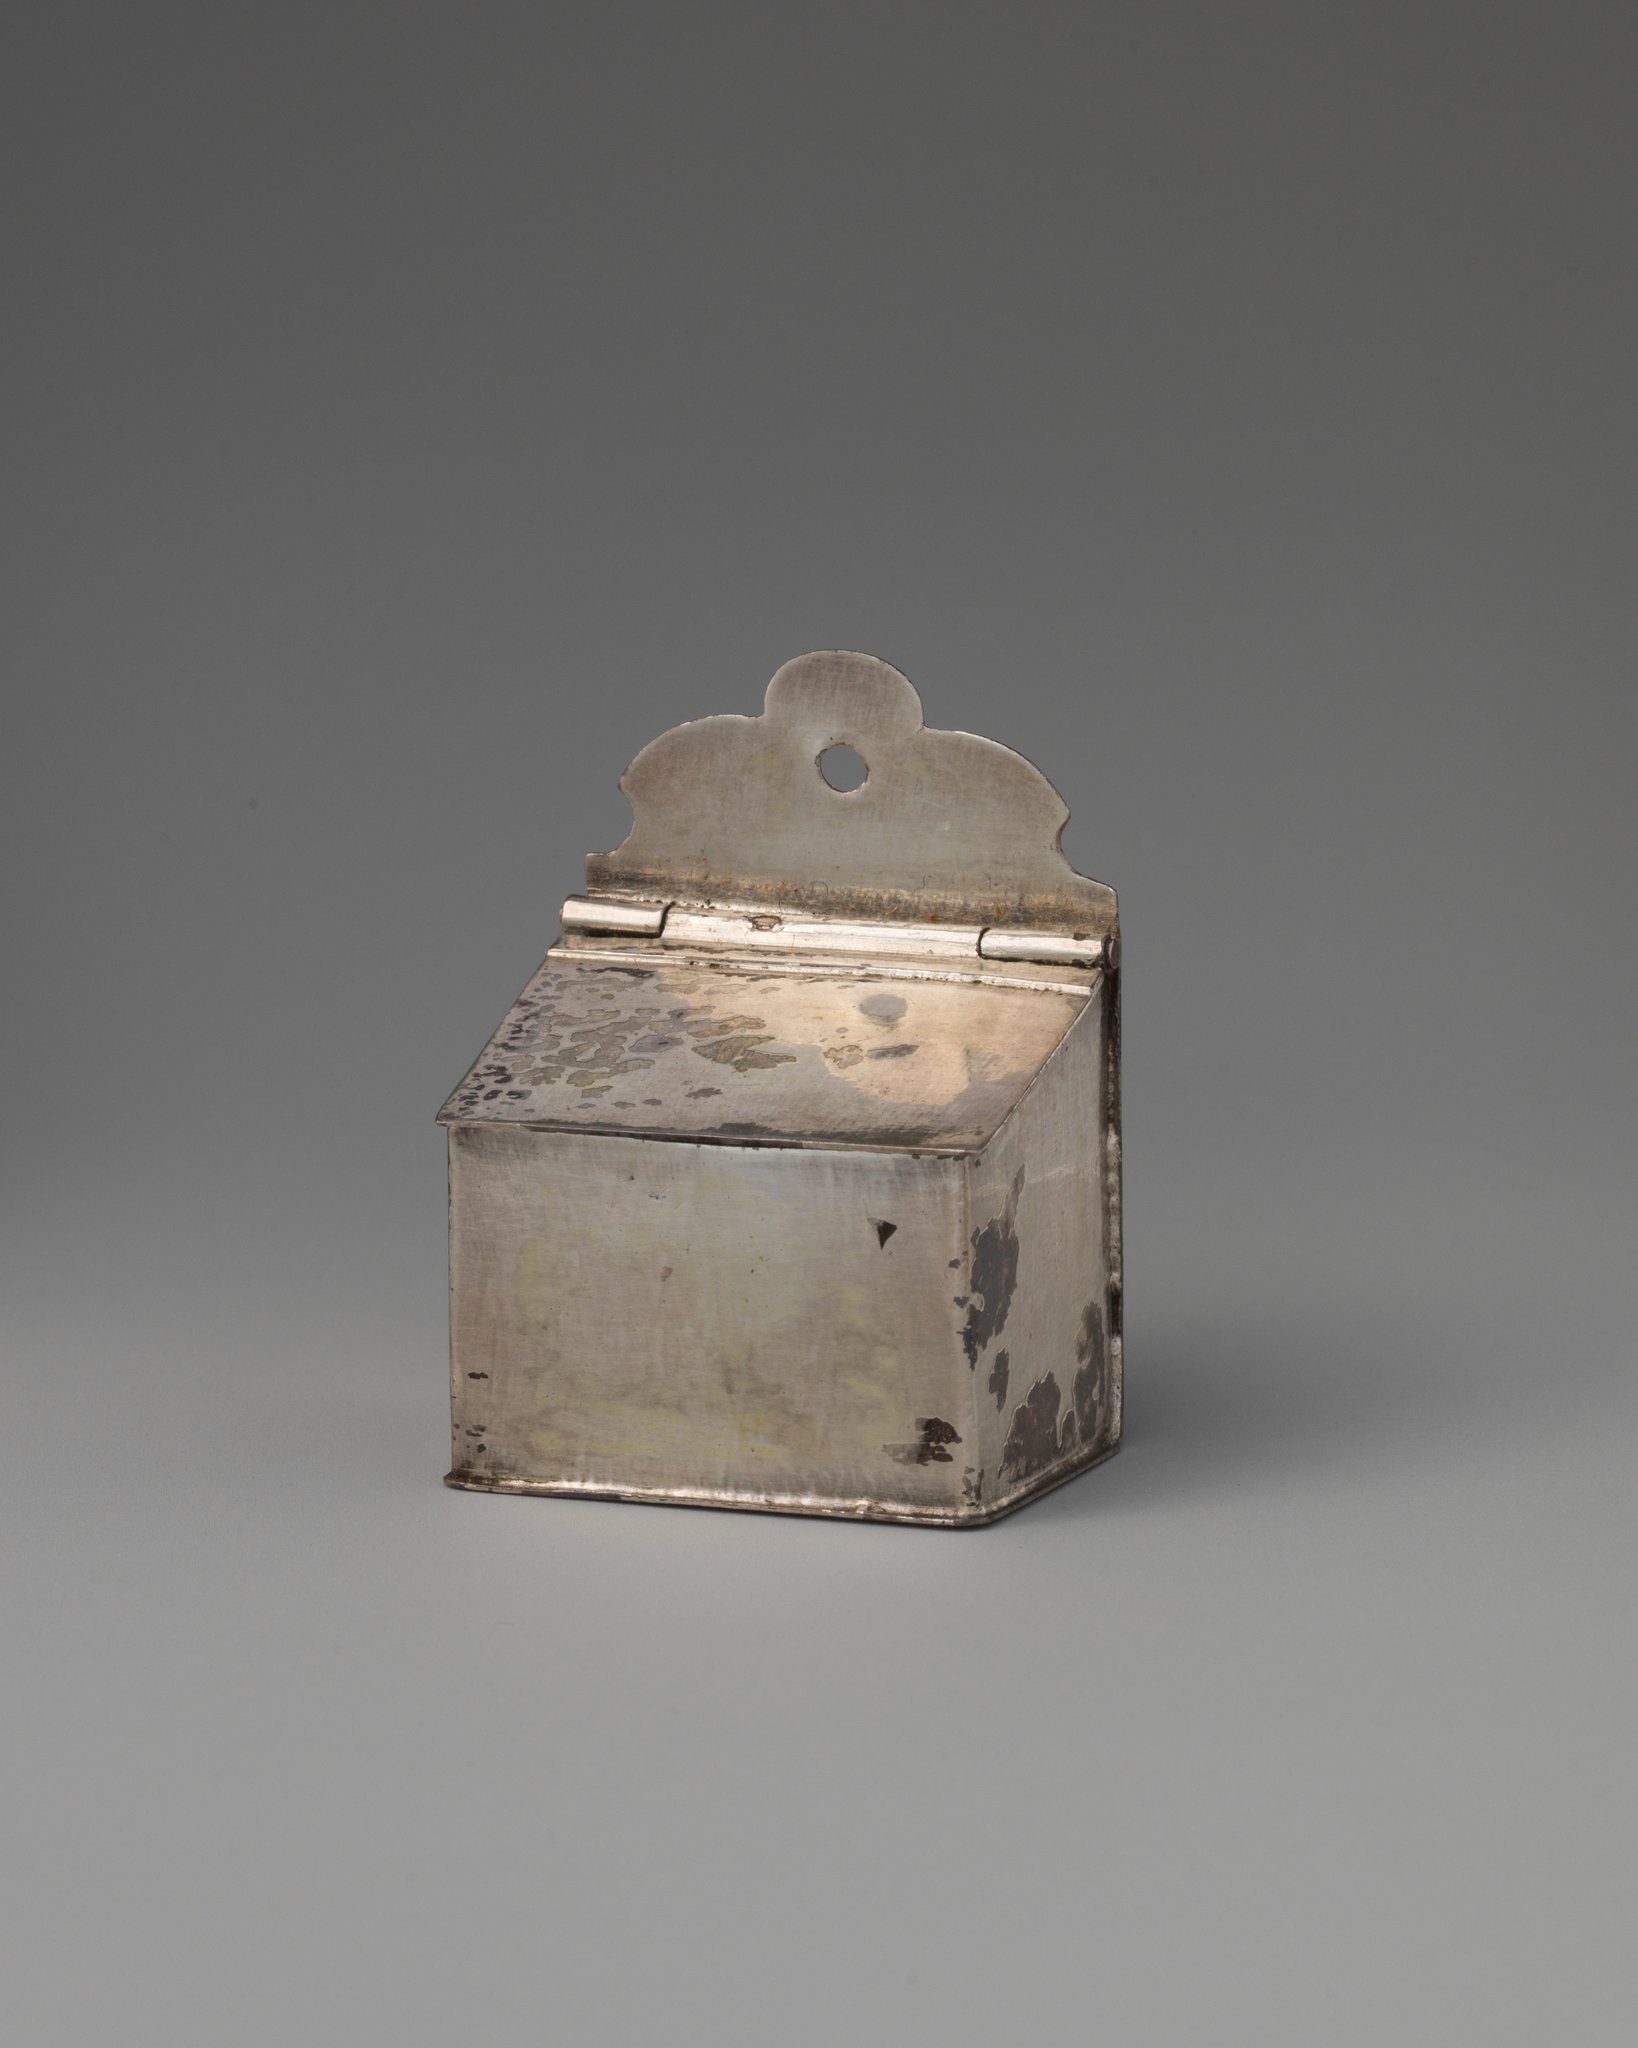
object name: salt box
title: Miniature salt box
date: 1701-1800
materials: silver